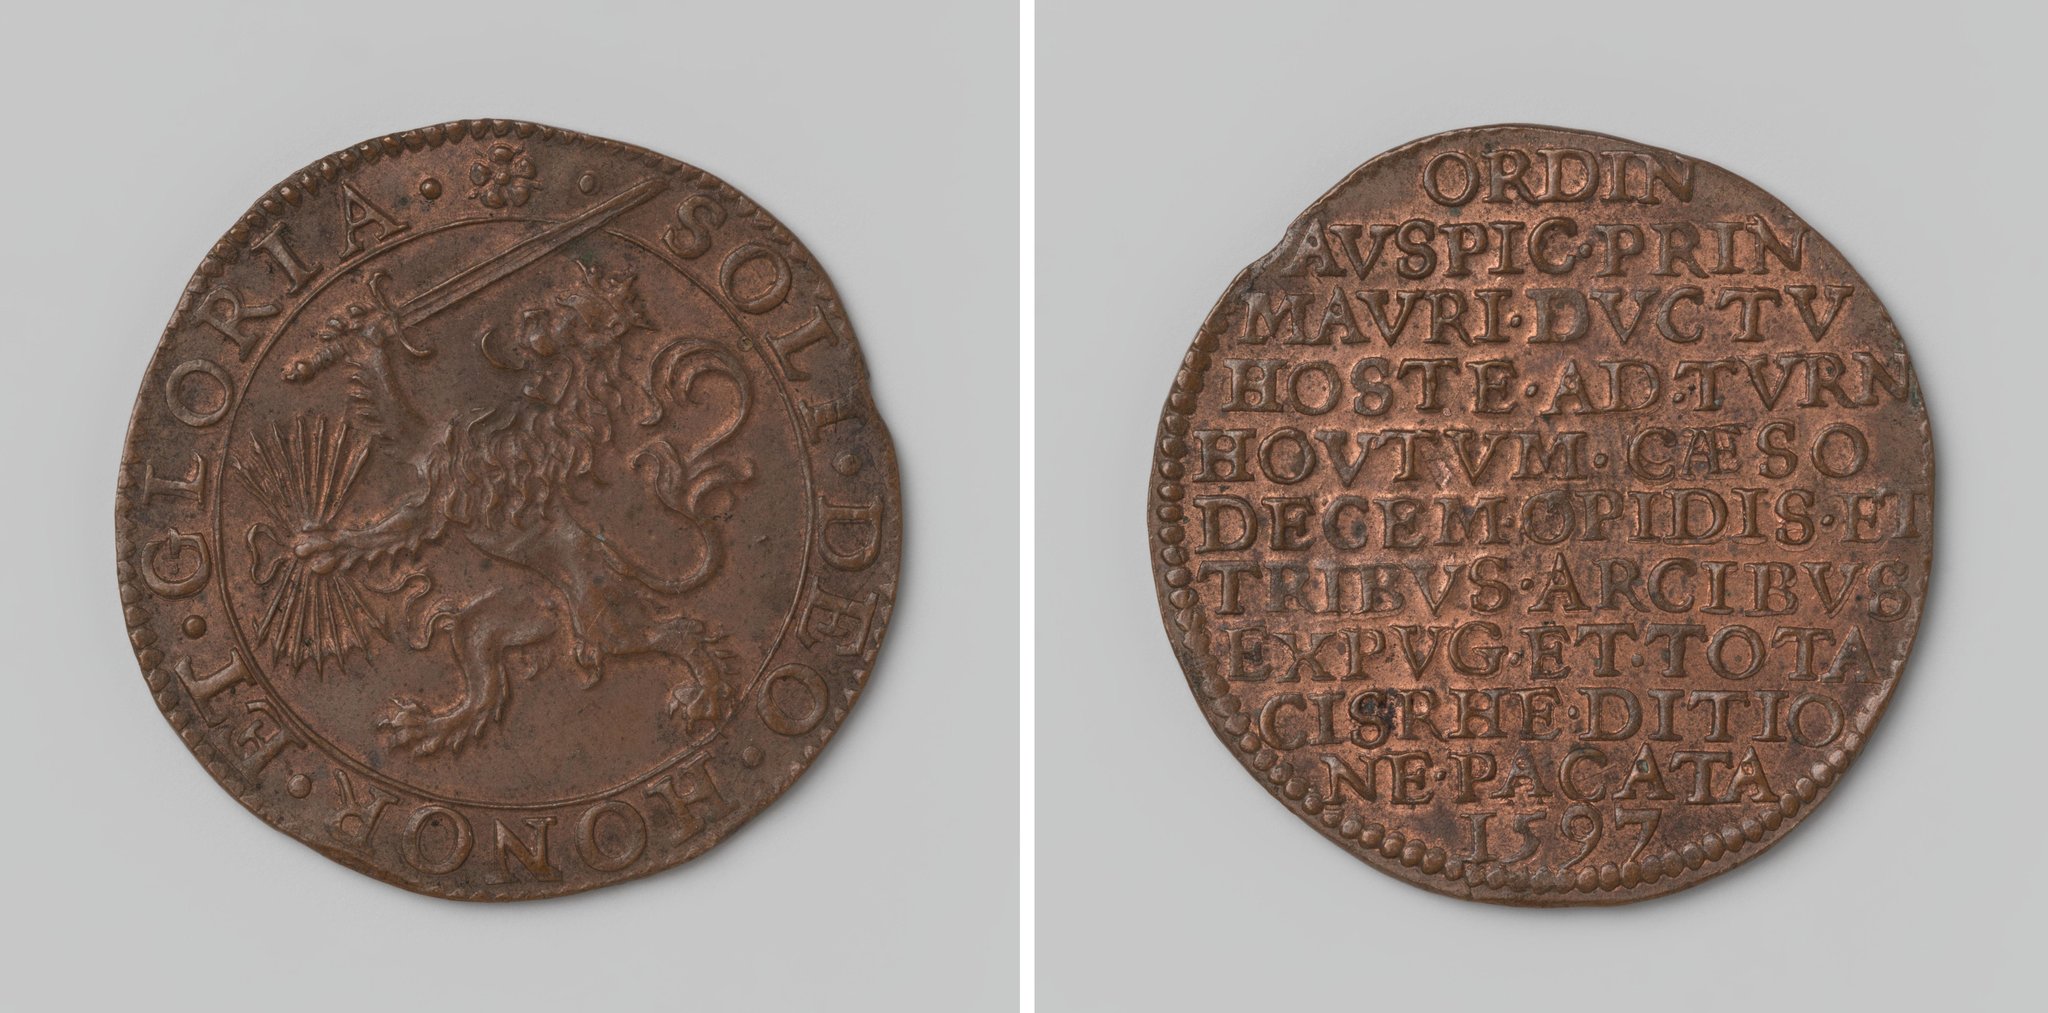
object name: jeton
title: Overwinning in de slag bij Turnhout en het innemen van tien steden en drie versterkingen door Maurits, graaf van Nassau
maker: Anonymous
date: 1597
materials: copper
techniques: striking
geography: dordrecht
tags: the hague, maurice (prince of orange)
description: Koperen penning. Voorzijde: leeuw met zwaard en bundel van zeven pijlen in klauwen binnen omschrift. Keerzijde: opschrift